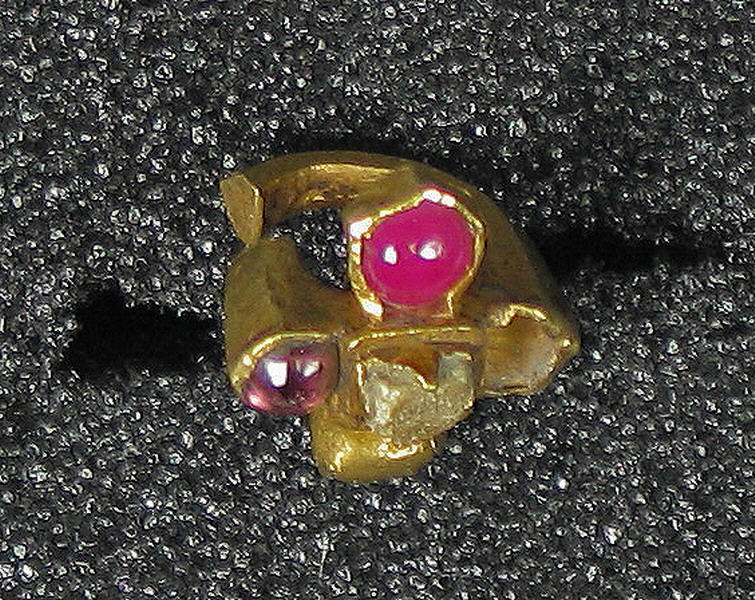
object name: earring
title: Earring, Quatreform with Rubies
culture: indonesian, central java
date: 701-1200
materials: gold